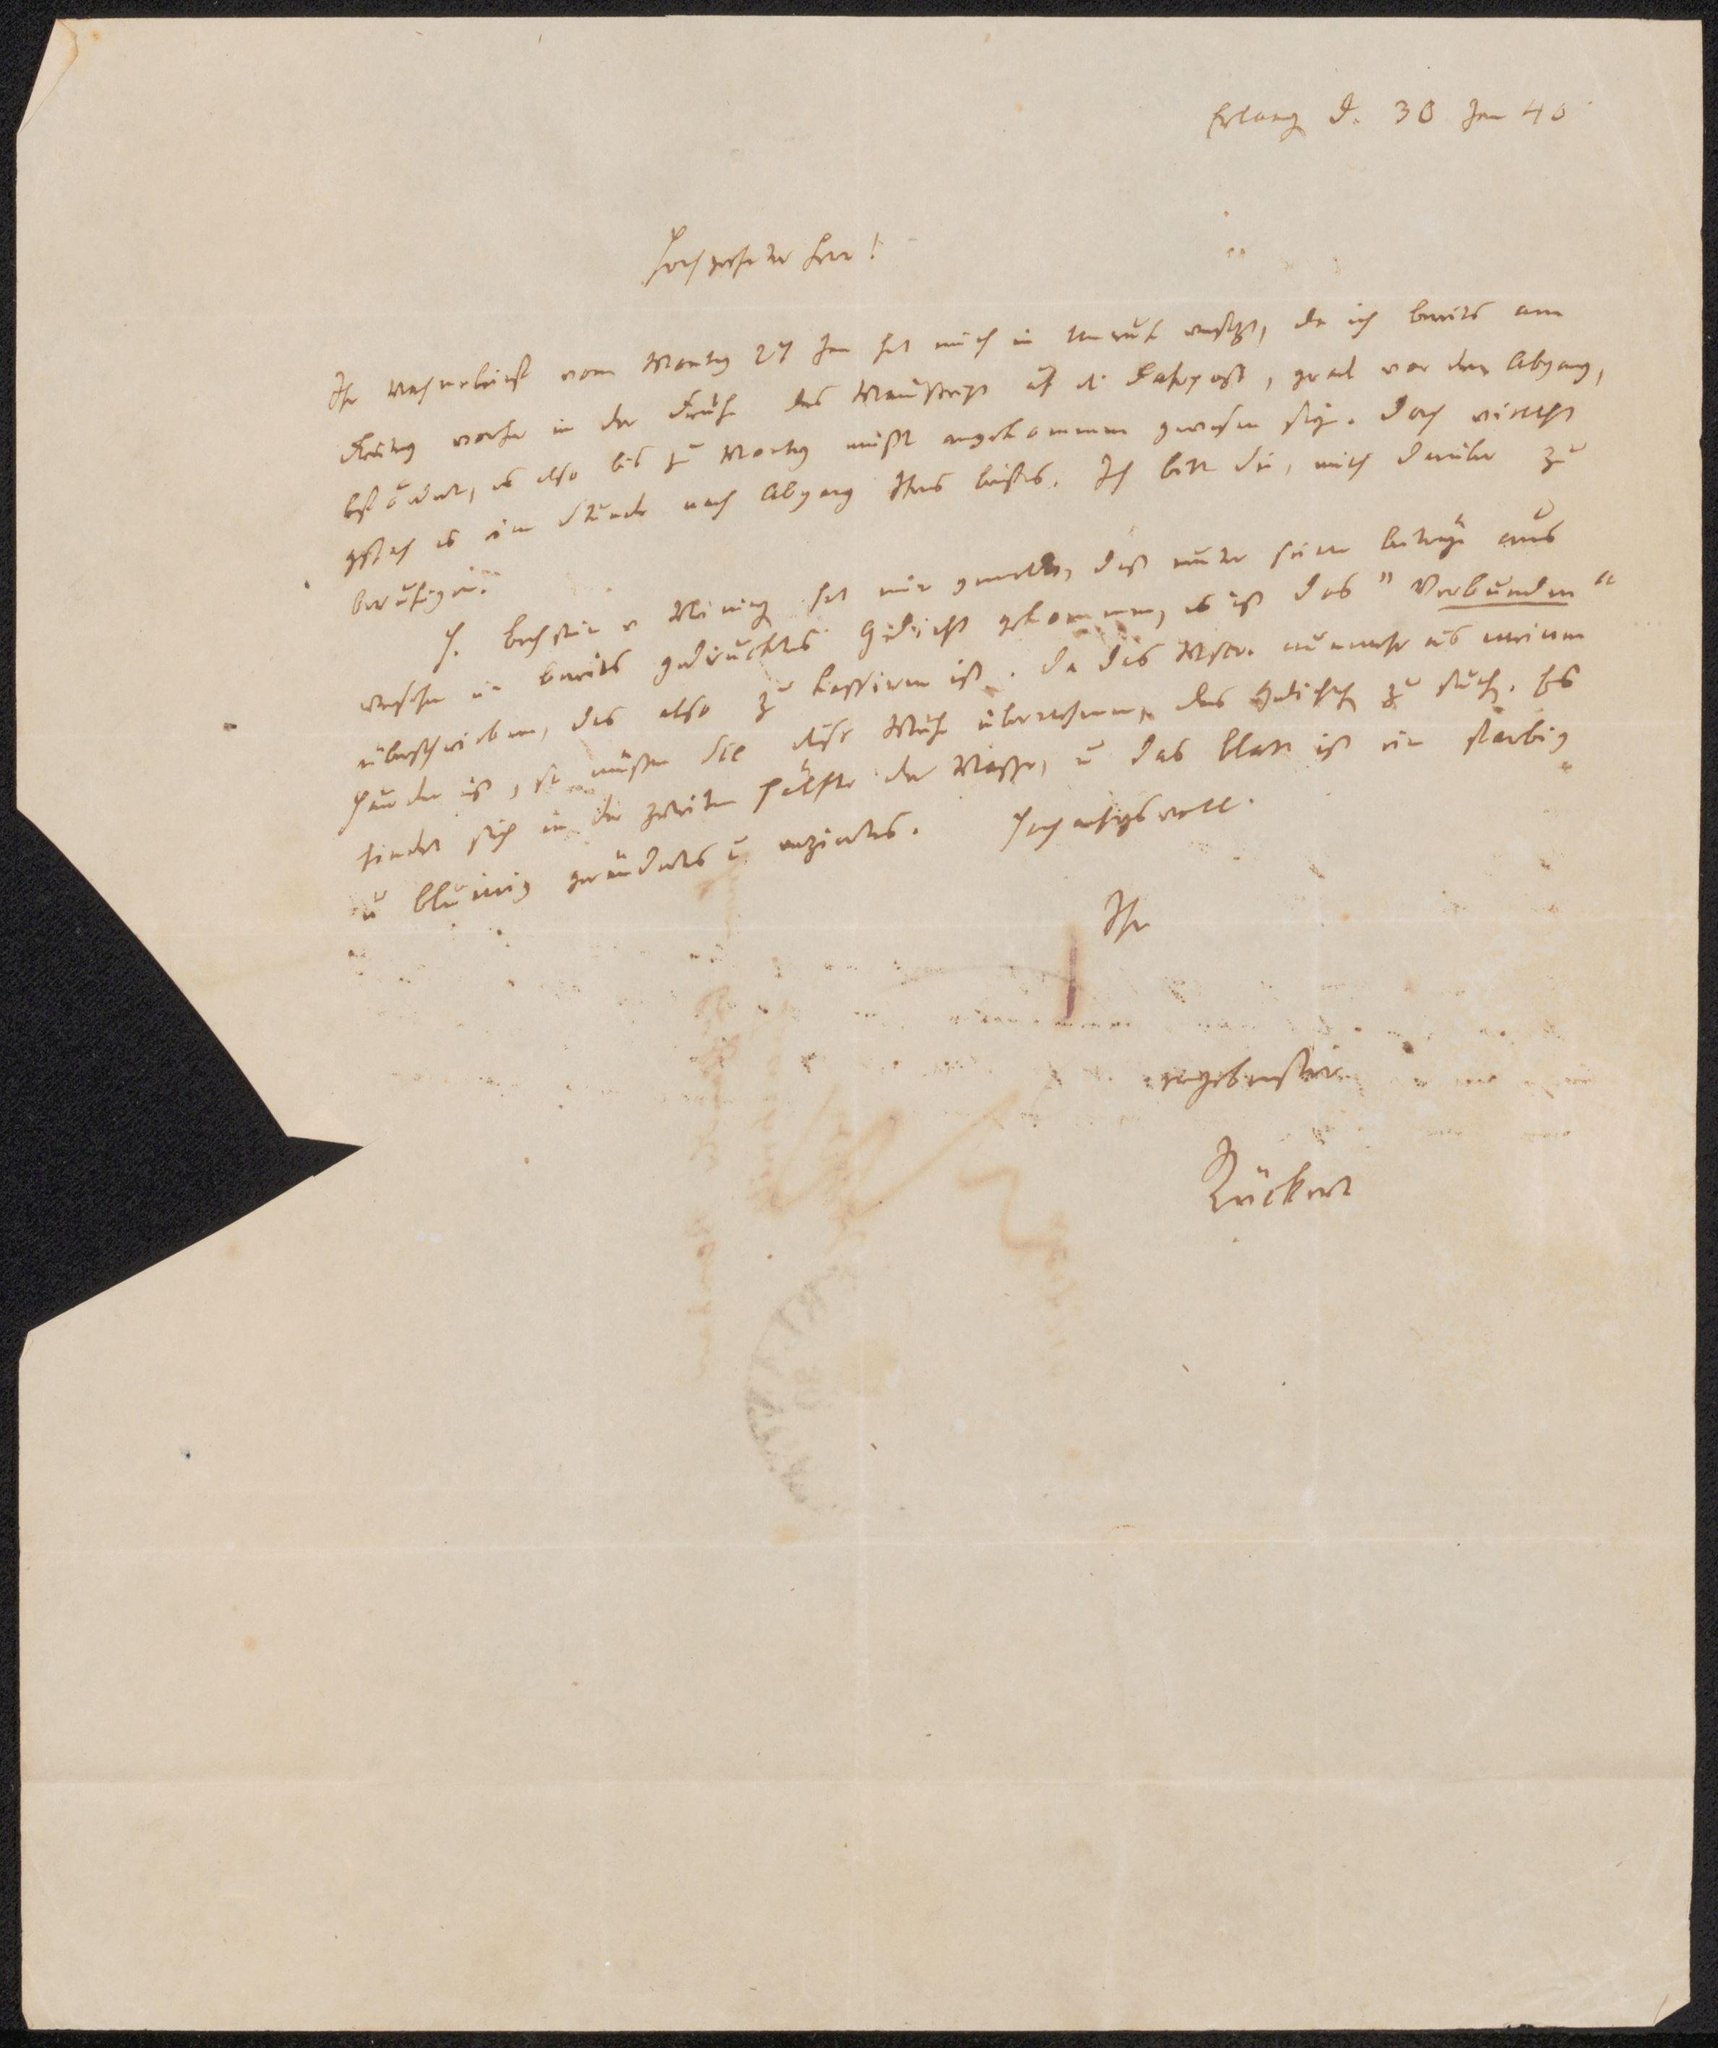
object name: letter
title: Brief aan Bernhard Tauchnitz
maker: friedrich rückert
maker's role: dichter, schrijver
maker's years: 1788-1866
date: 1840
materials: ink, paper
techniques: pen, writing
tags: bernhard tauchnitz, printed matter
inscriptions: collector's mark: Lugt 2228